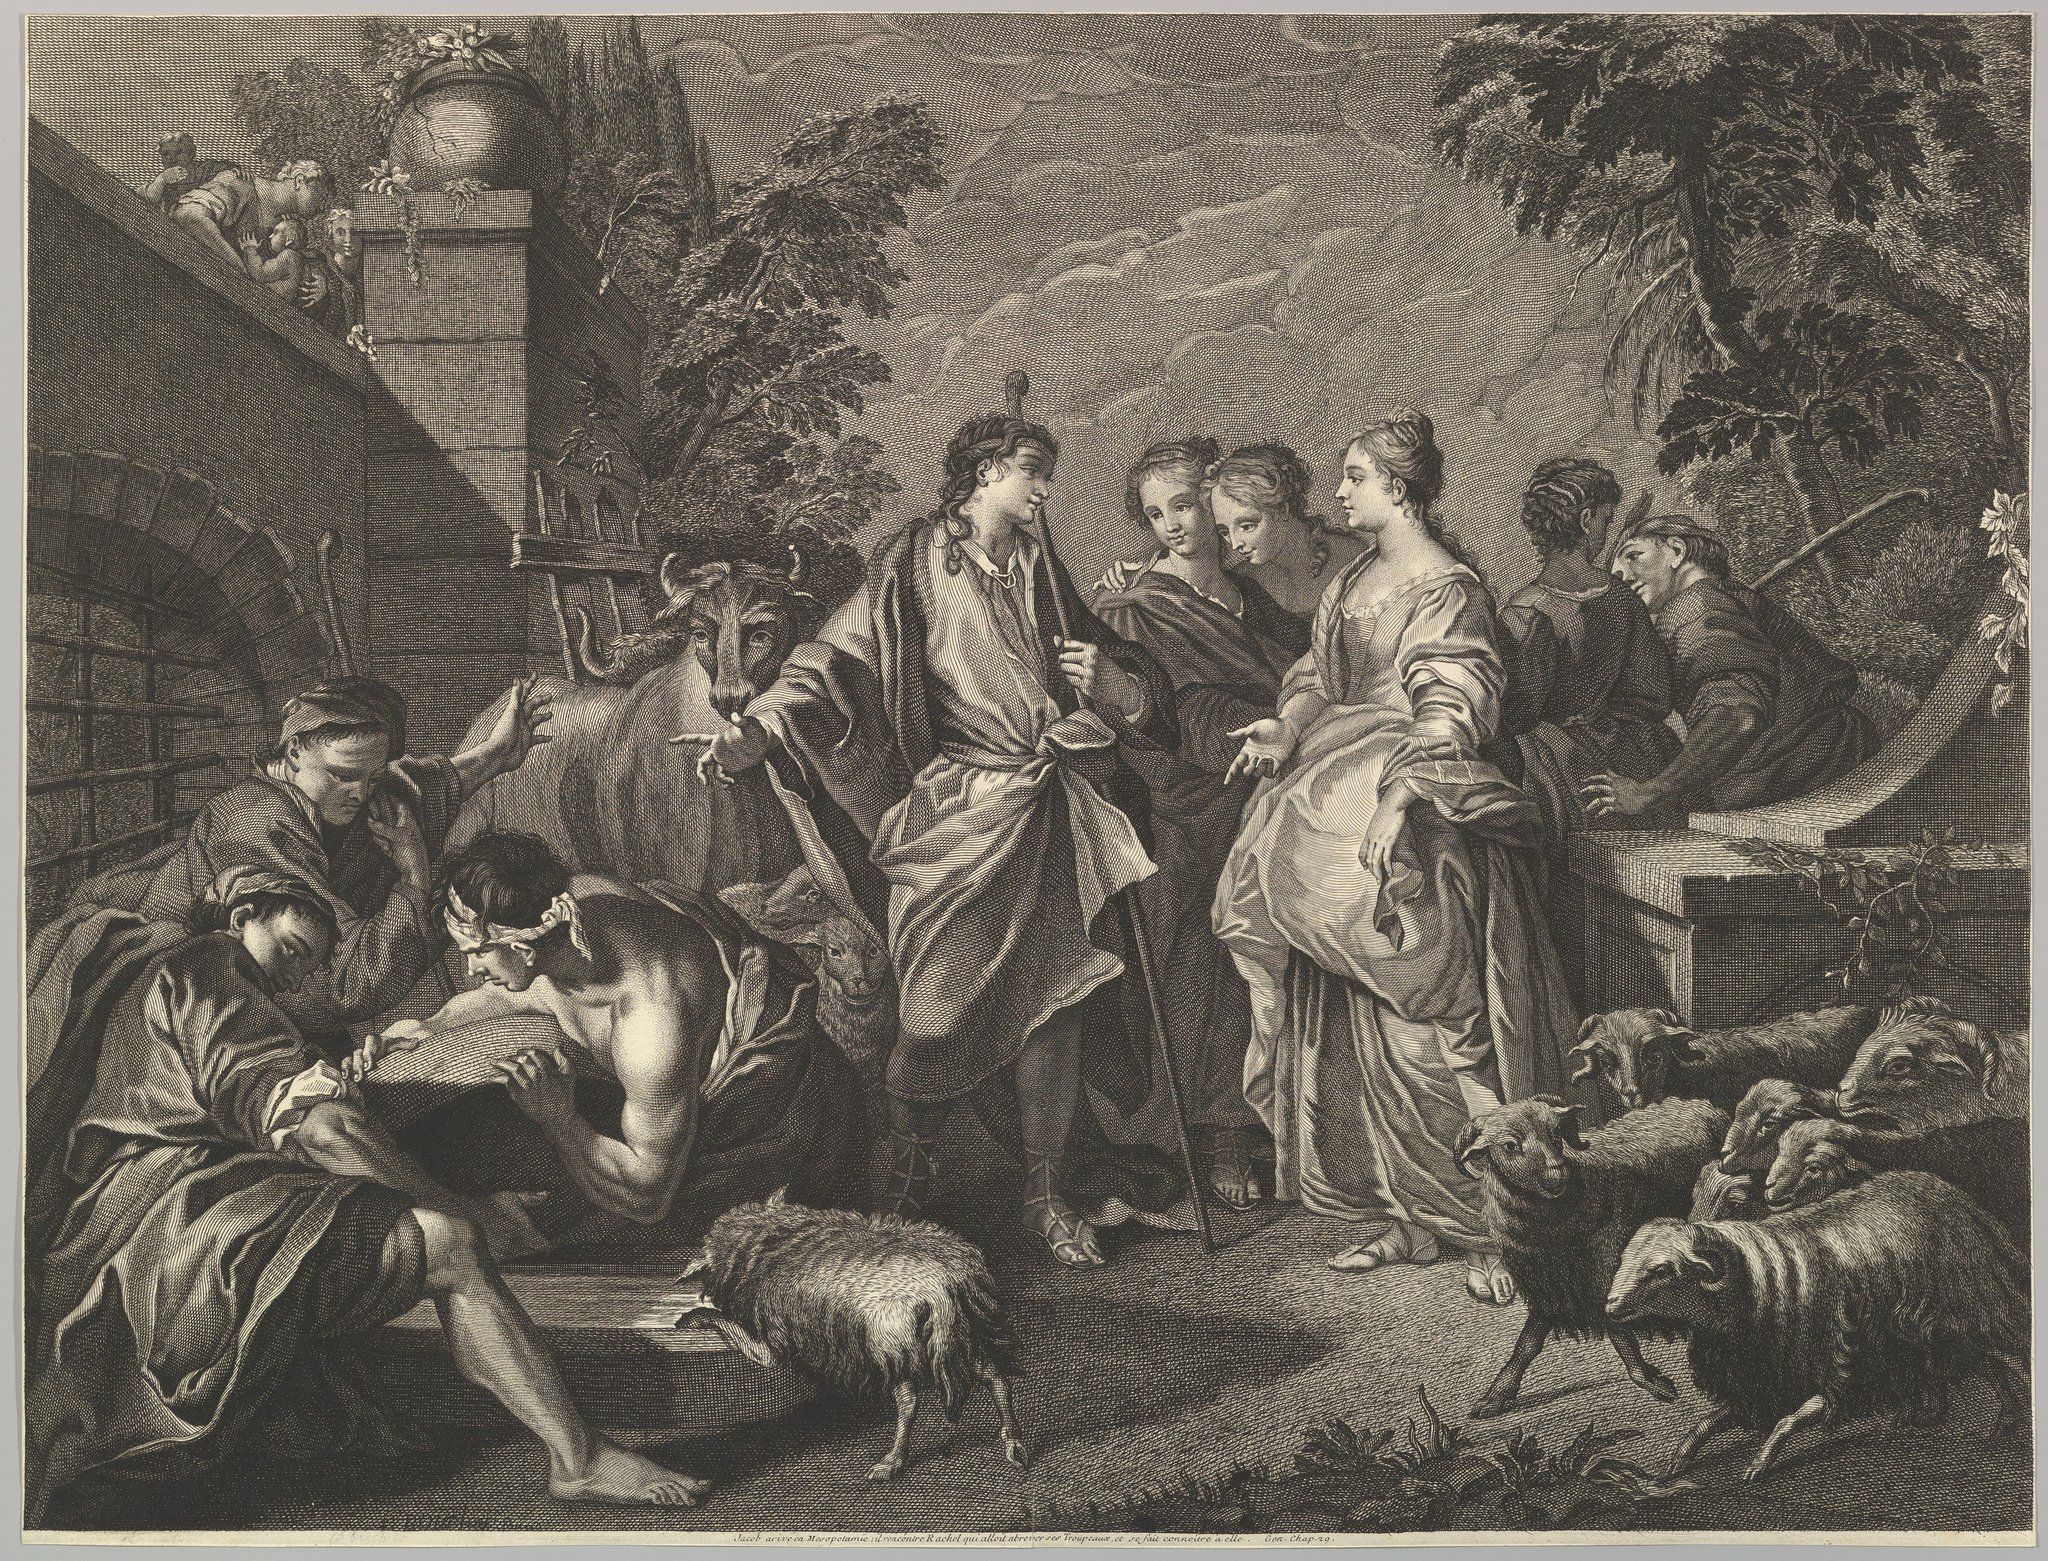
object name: print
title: Jacob arrives in Mesopotamia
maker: Anonymous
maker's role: artist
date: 1701-1800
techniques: engraving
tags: men,women,sheep